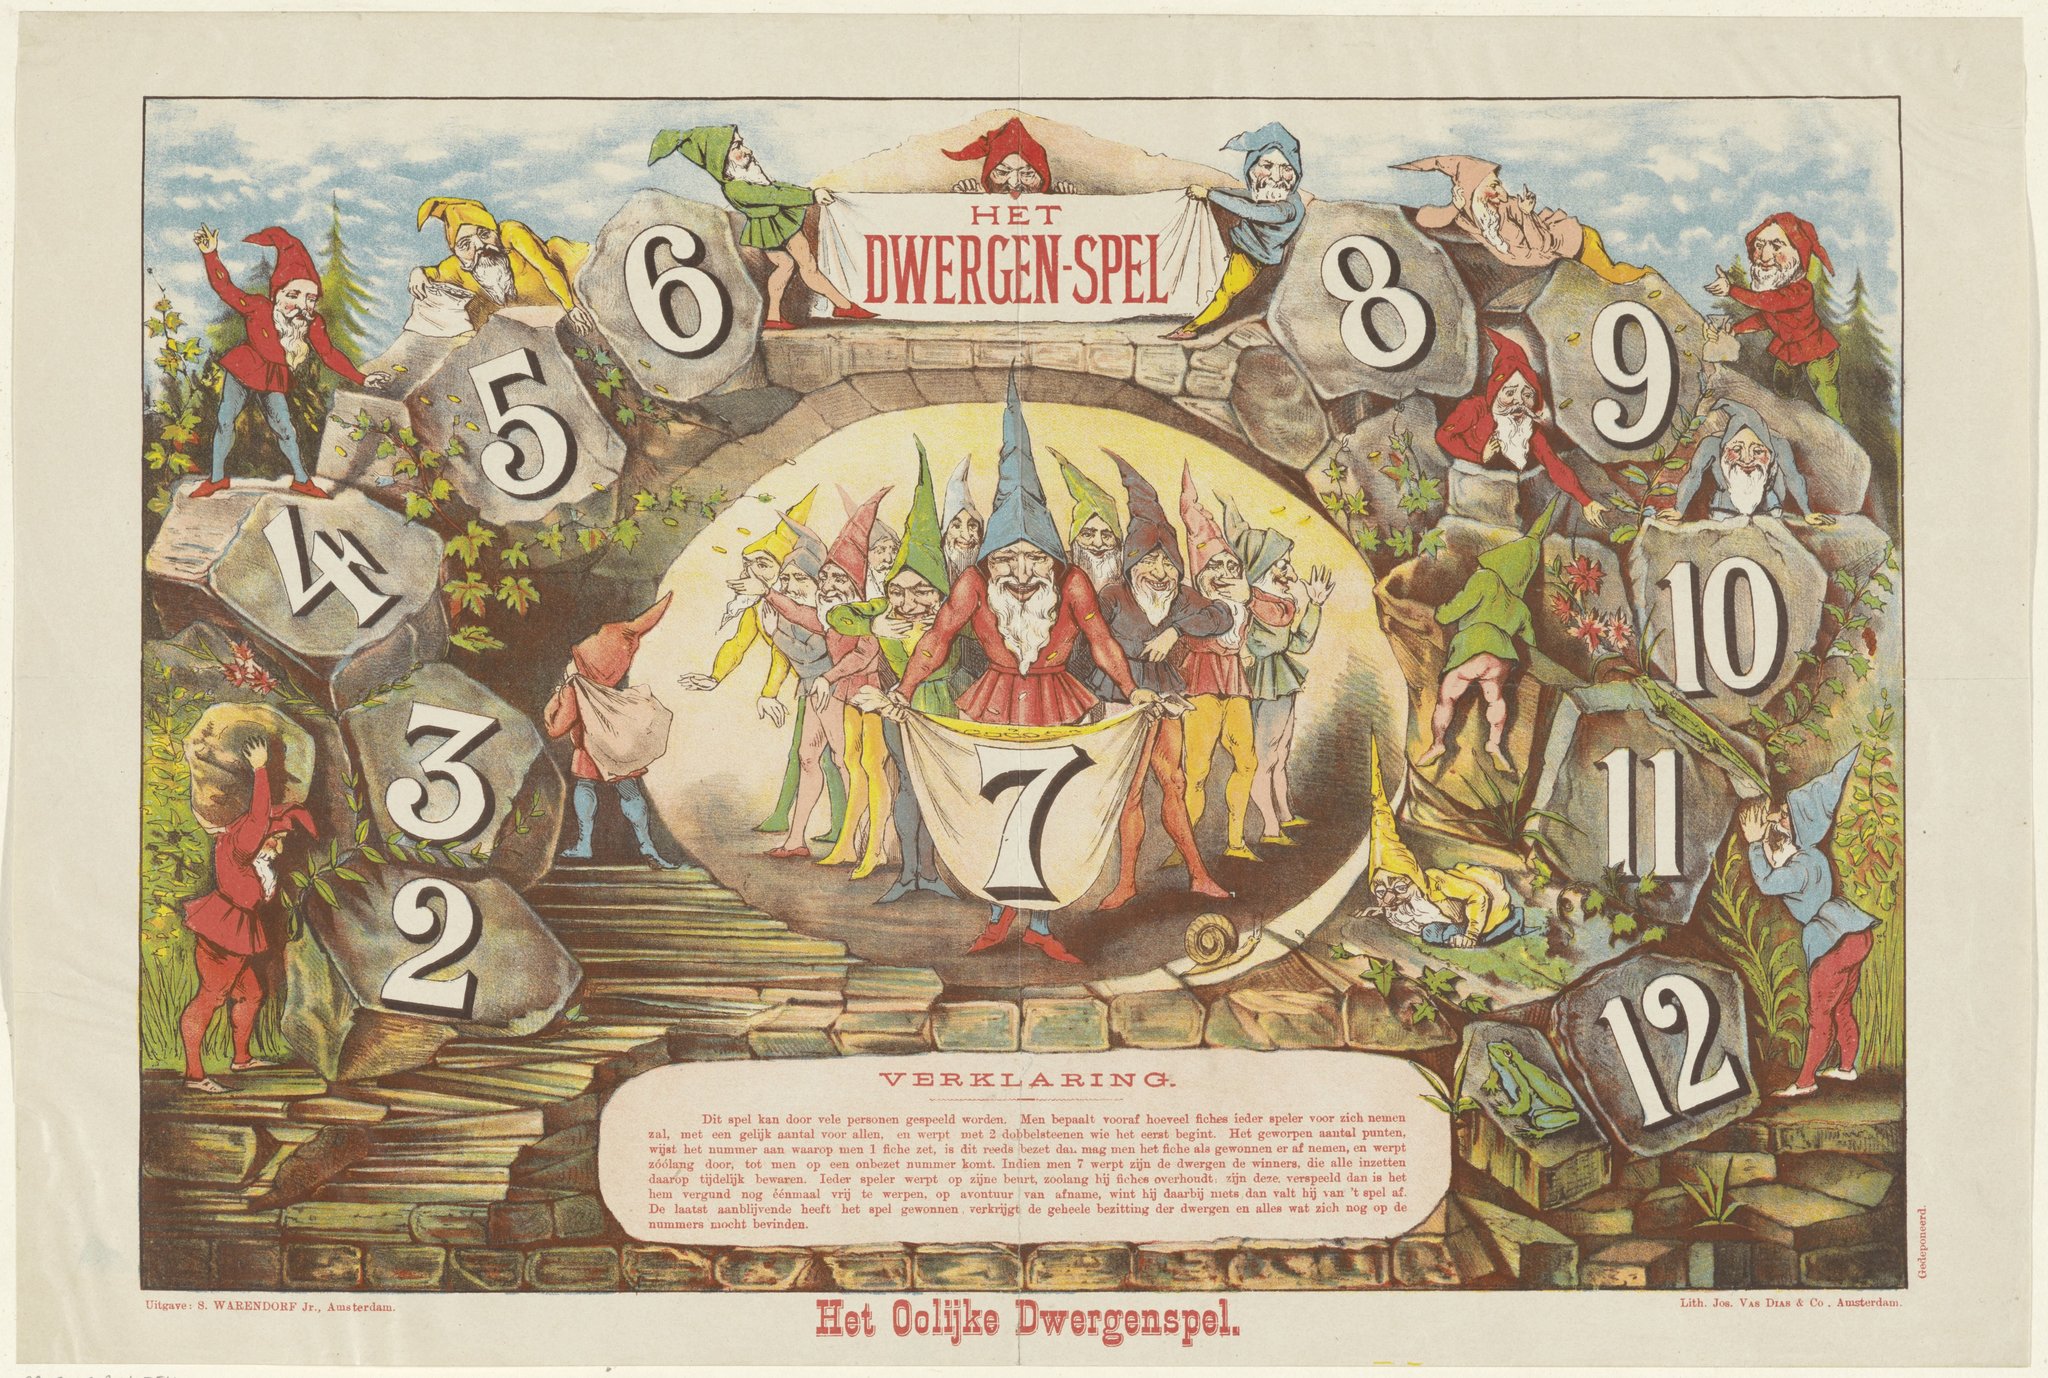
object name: gameboard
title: Het oolijke dwergenspel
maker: s. warendorf (ii)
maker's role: publisher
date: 1887-1891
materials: paper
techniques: lithograph, letterpress printing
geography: amsterdam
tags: board-games of chance, board-games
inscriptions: collector's mark: Lugt 2760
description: Bordspel met in het midden een tiental dwergen met groot het getal zeven op een zak met goudstukken. Daaromheen de cijfers 2-12 en allerlei bezige dwergen. Midden boven de titel op een spandoek dat gedragen wordt door drie dwergen. Midden onder de spelregels.